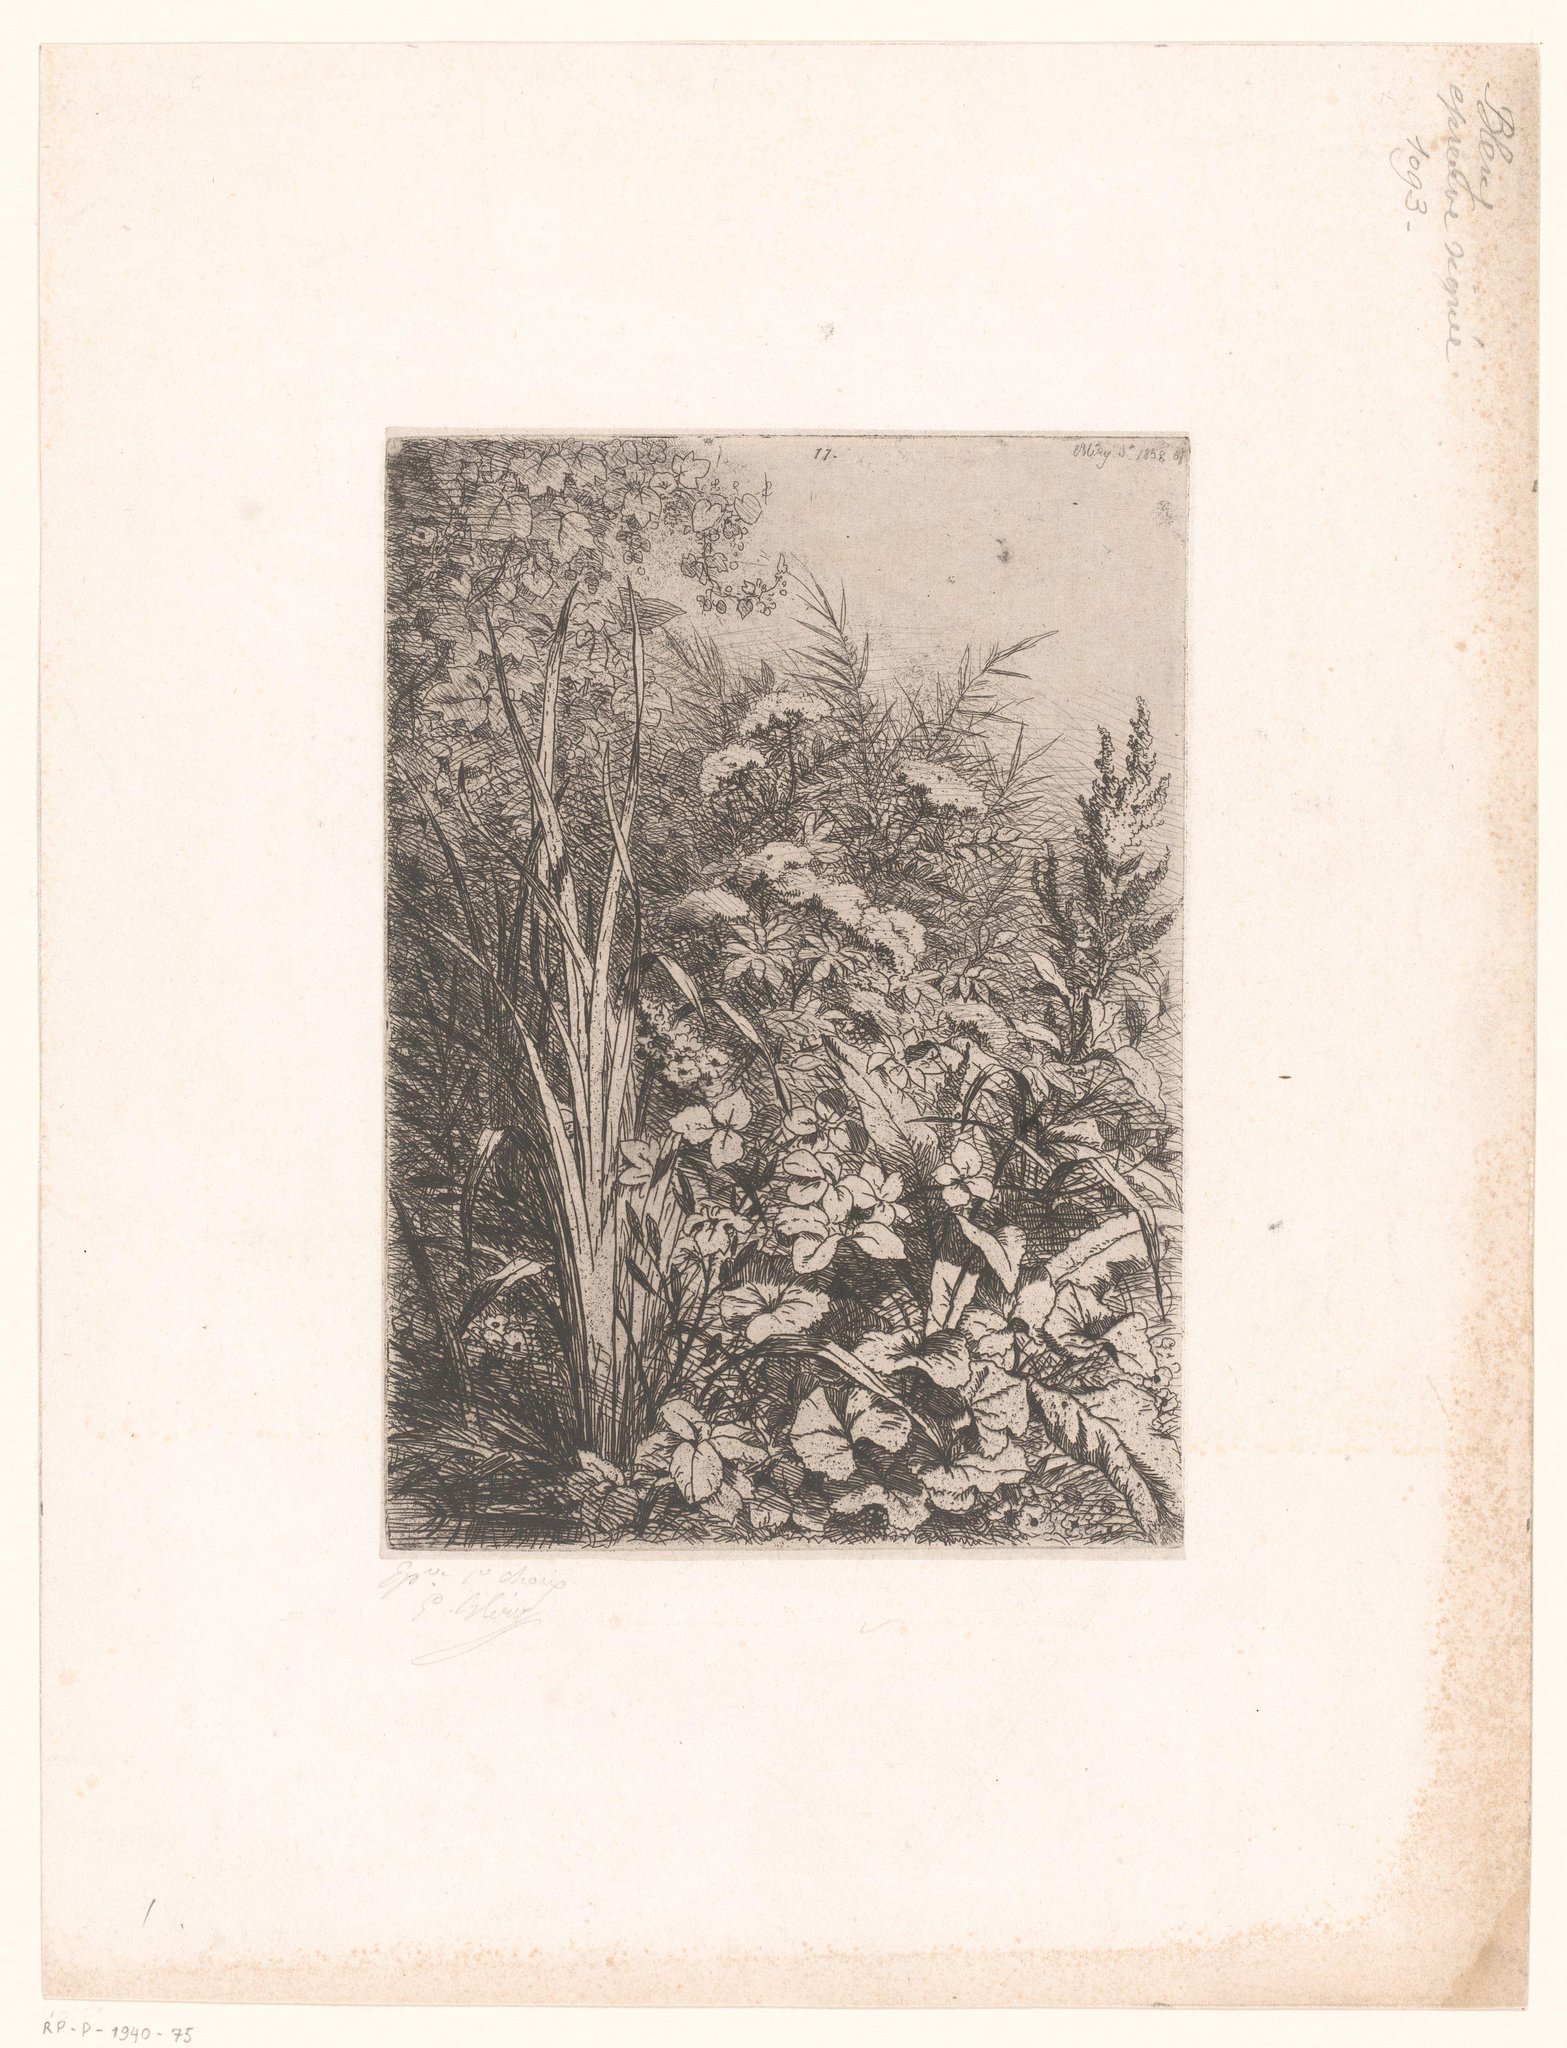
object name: print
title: Planten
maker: eugène bléry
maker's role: print maker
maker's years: 1805-1887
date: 1858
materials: paper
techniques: aquatint, drypoint, engraving, etching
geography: france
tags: plants (in general)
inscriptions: collector's mark: Lugt 2166, collector's mark: Lugt 2760